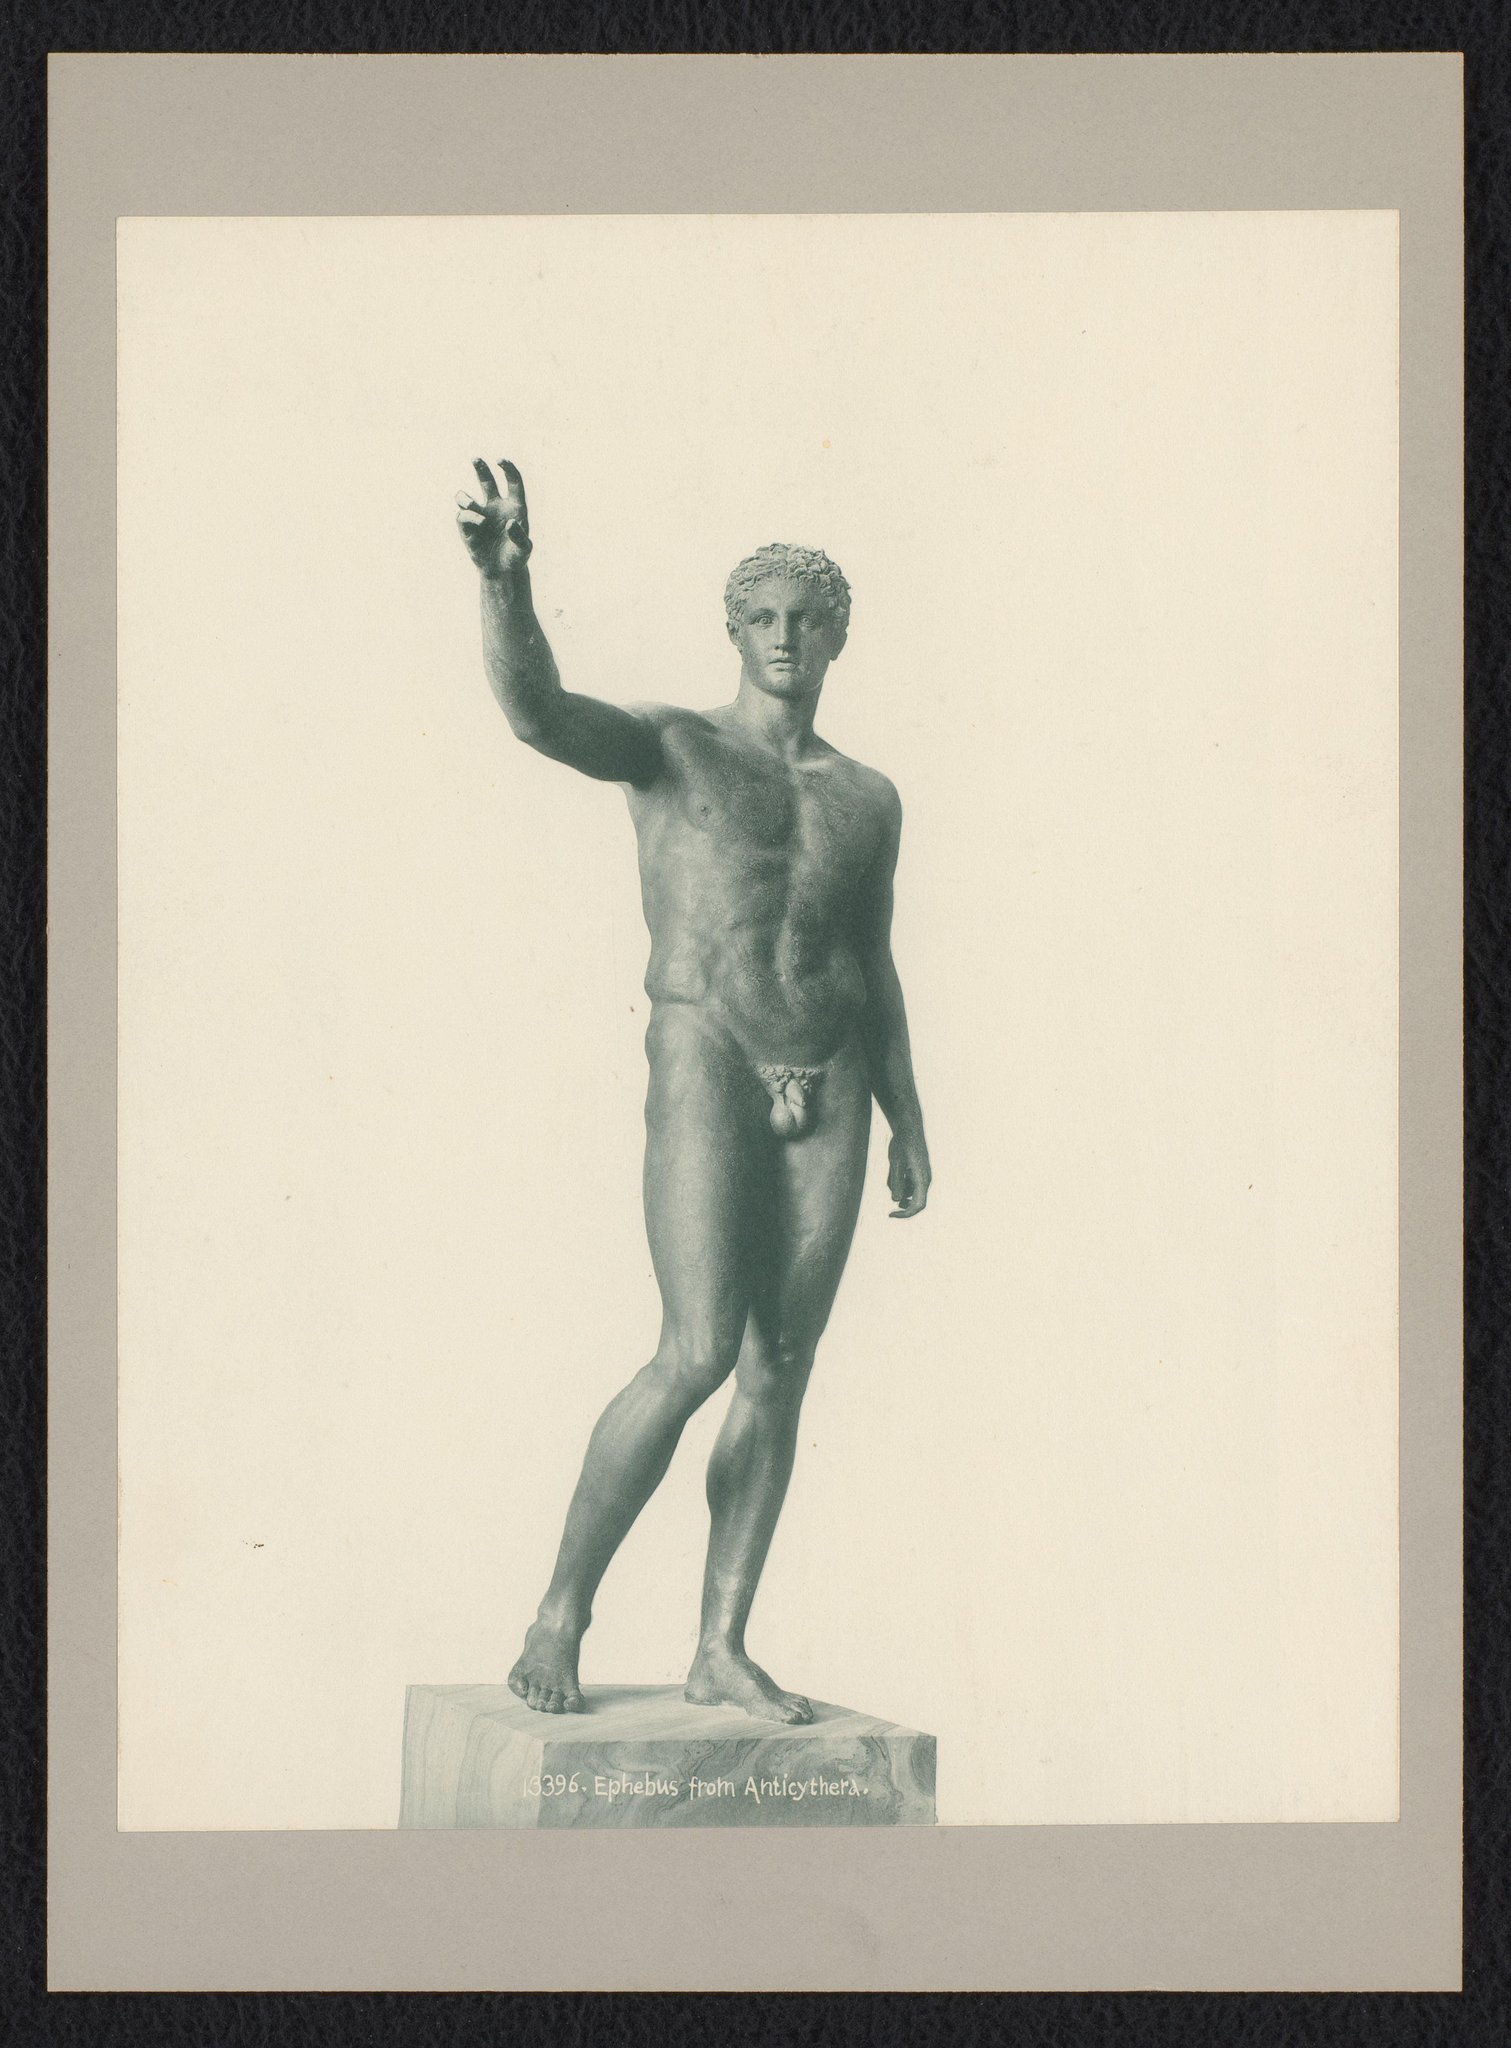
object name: photograph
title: Beeld van Ephebus van Antikythera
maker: Anonymous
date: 1895-1915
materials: cardboard, paper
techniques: photograph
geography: athens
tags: athene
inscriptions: number: ‘40.’